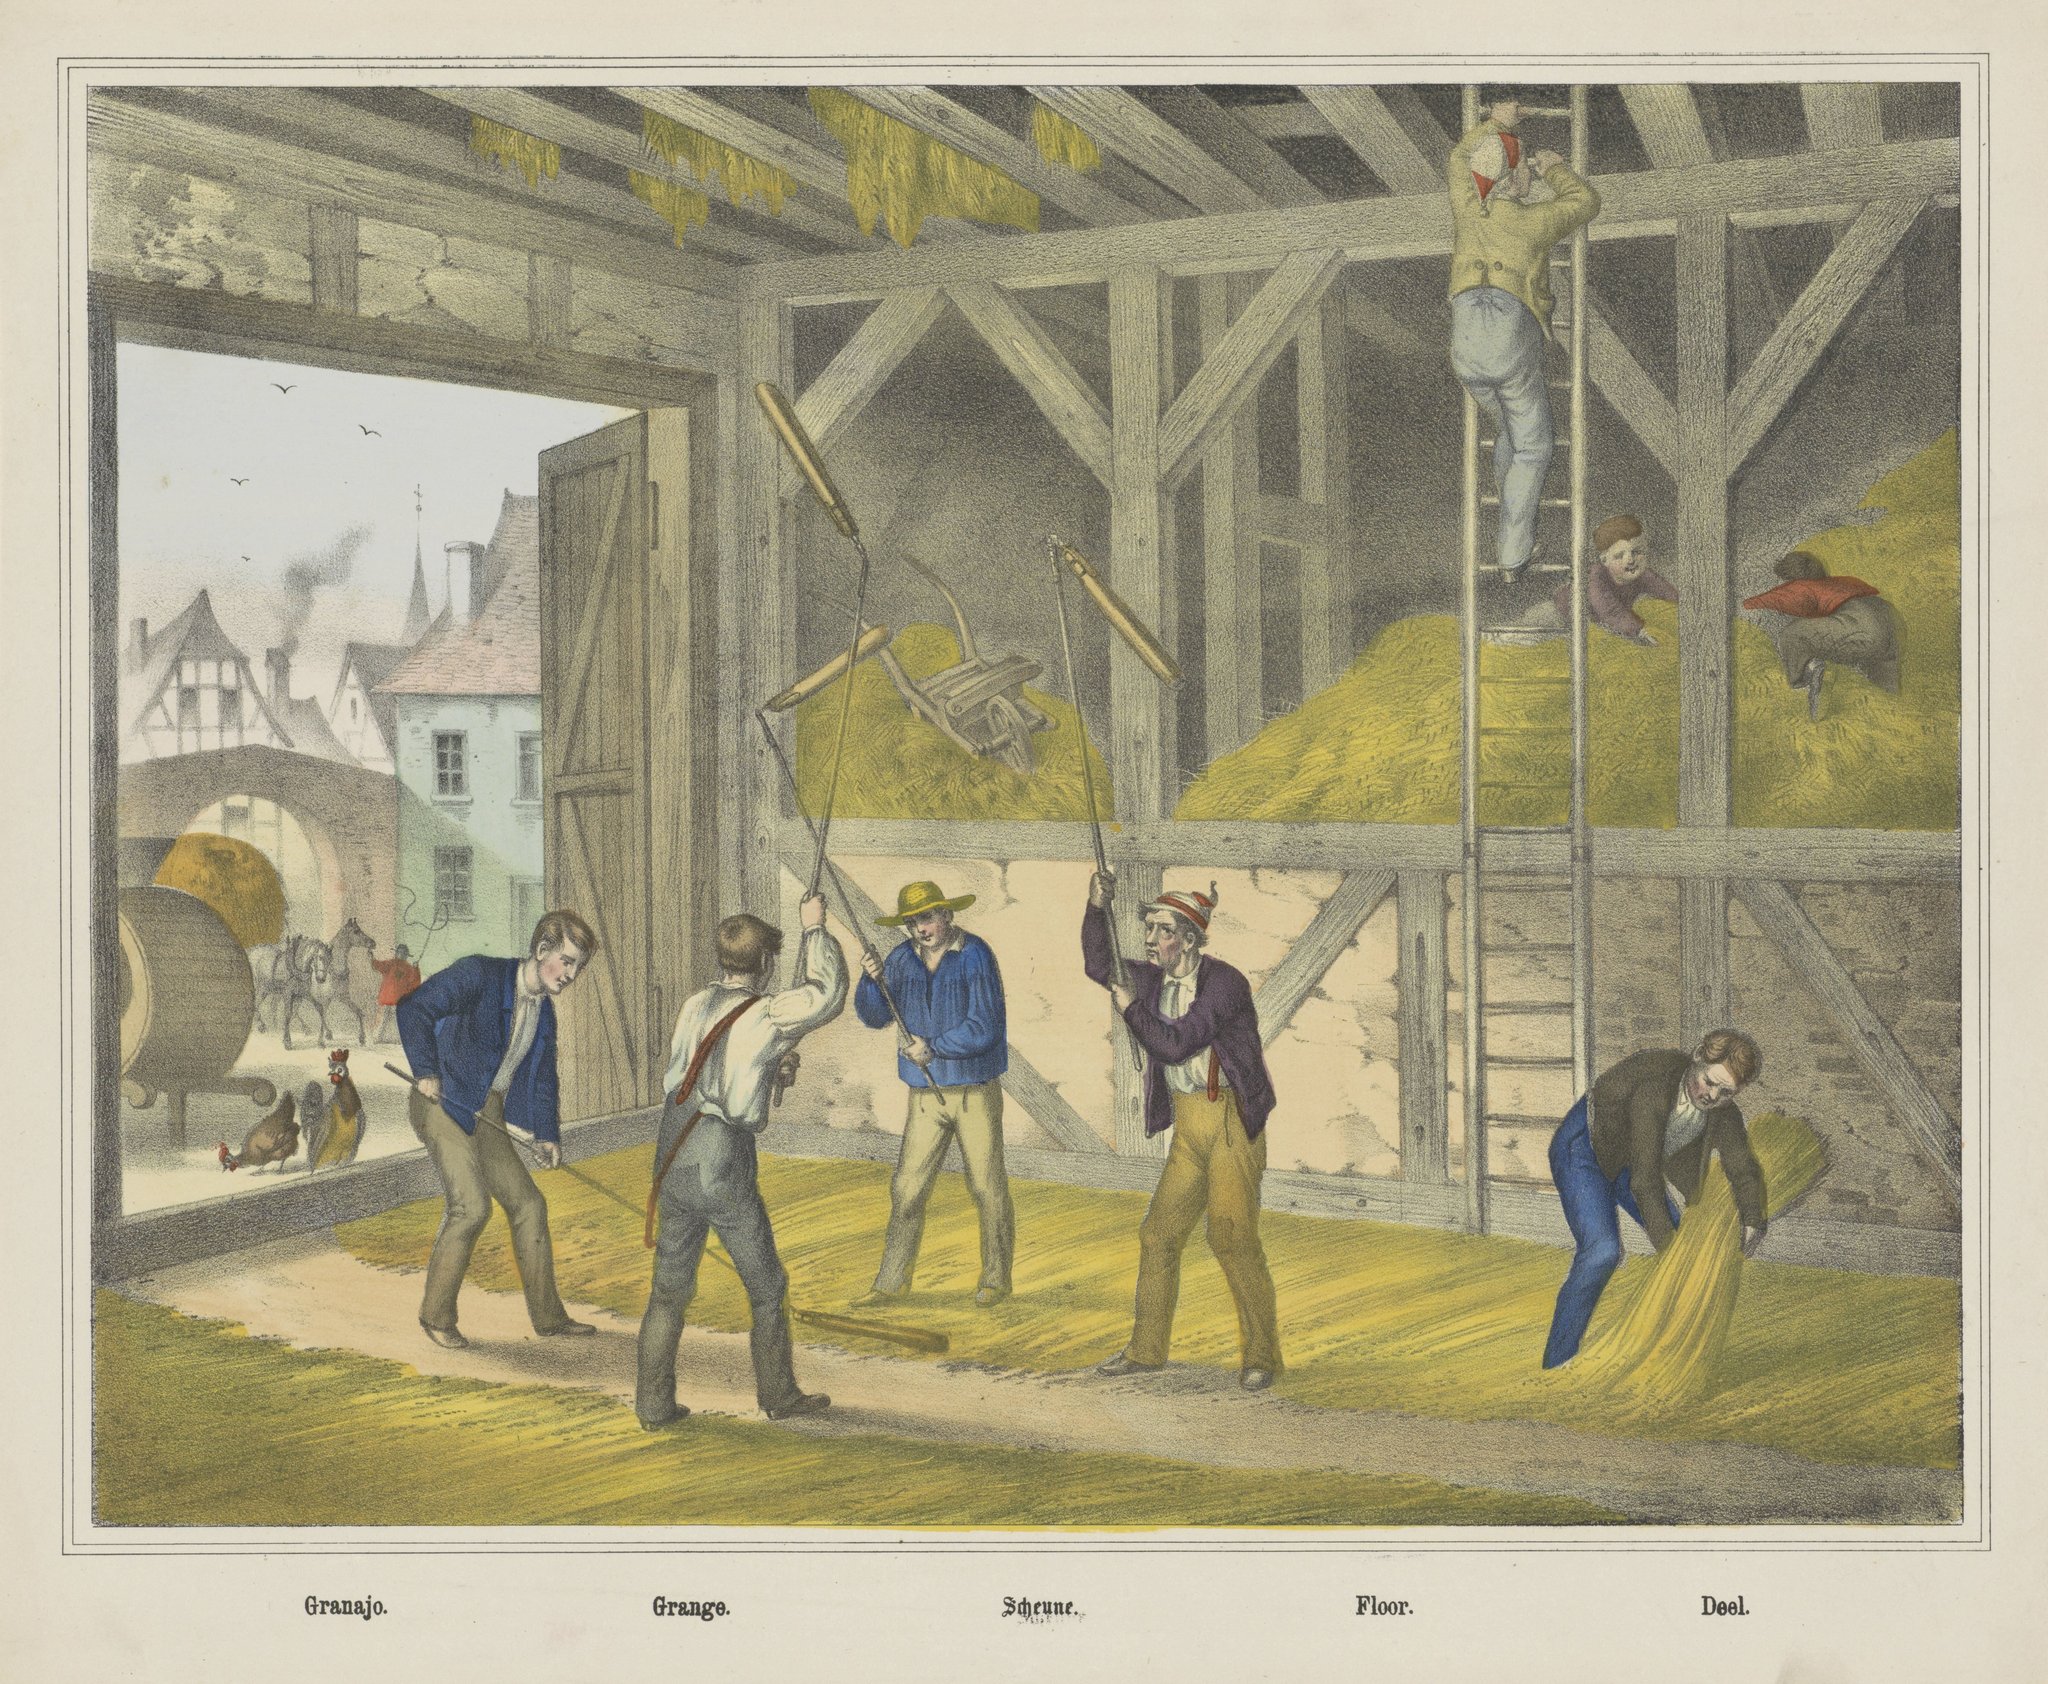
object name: popular print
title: Granajo. / Grange. / Scheune. / Floor. / Deel.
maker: j. scotti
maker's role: print maker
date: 1829-1880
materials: paper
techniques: colour, lithograph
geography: europe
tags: barn, cereal, grain, corn (grass with grains, grown for food, e.g.: wheat, rice, rye, oats, maize, buckwheat, millet)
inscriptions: collector's mark: Lugt 2760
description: Zicht in een graanschuur, waar mannen bezig zijn het graan uit het koren te slaan. Door de deur een doorkijk op een erf met kippen en twee paarden die een kar vol graan naar binnen rijden.